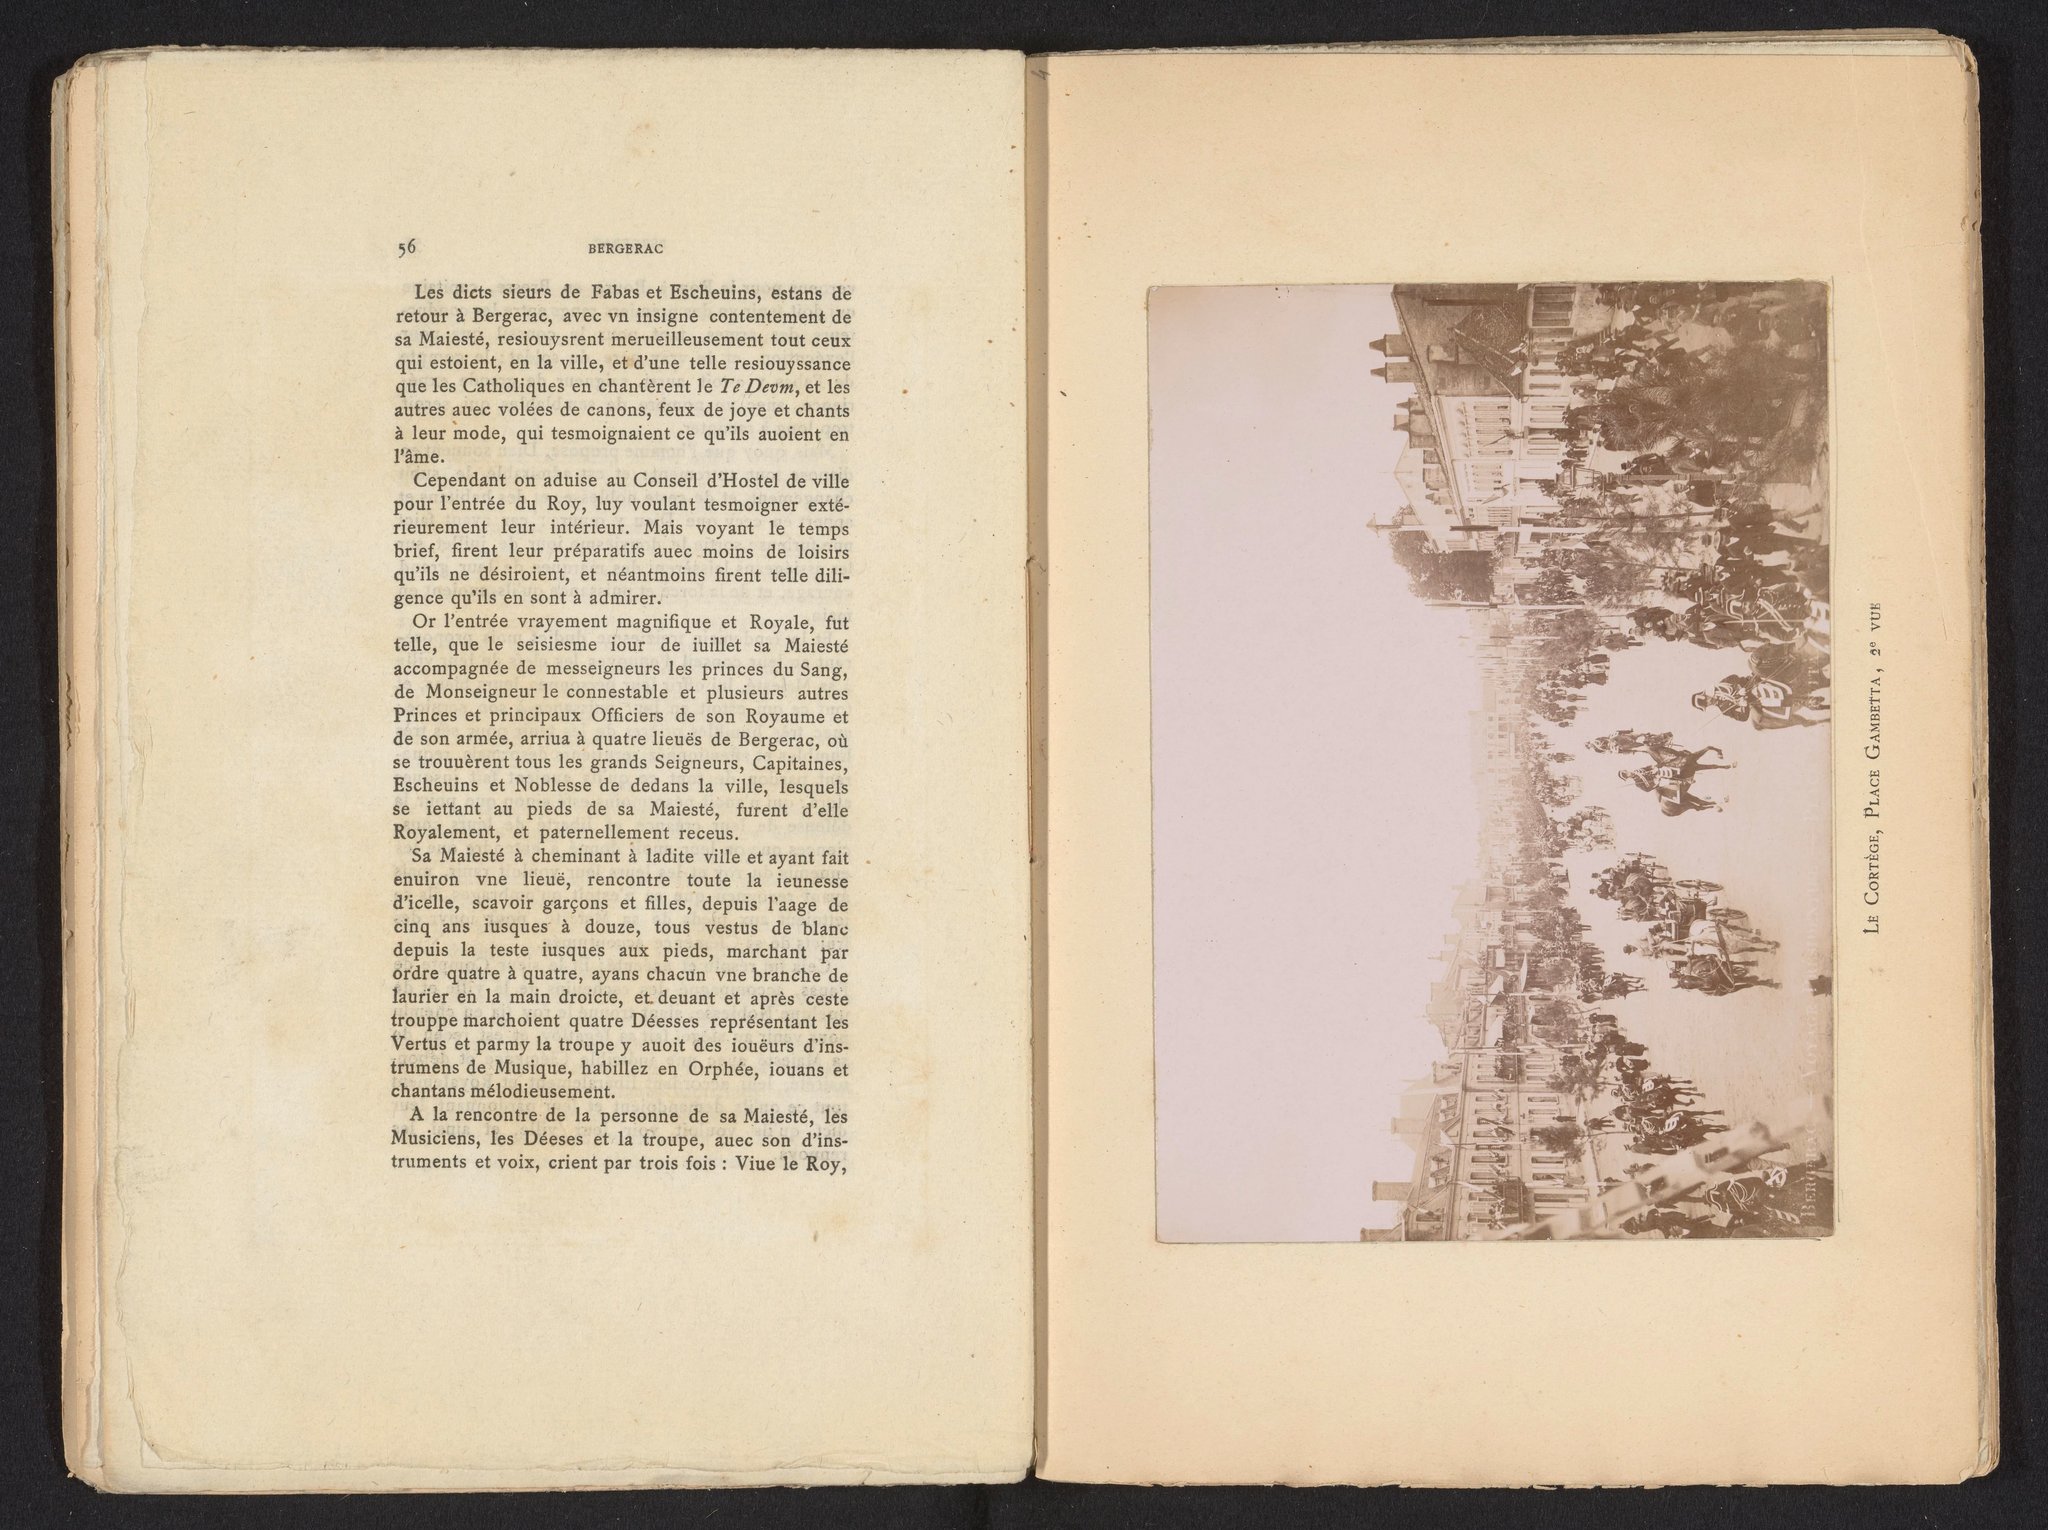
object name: page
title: Bergerac- Voyage presidentiel- Place Gambetta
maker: Anonymous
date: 1895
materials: photographic support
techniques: gelatin silver print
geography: bergerac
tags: square, place, circus, etc., triumphal entry and public reception, pageant, 'entrée solennelle', 'joyeuse entrée', façade (of house or building), four-wheeled vehicle drawn by two animals